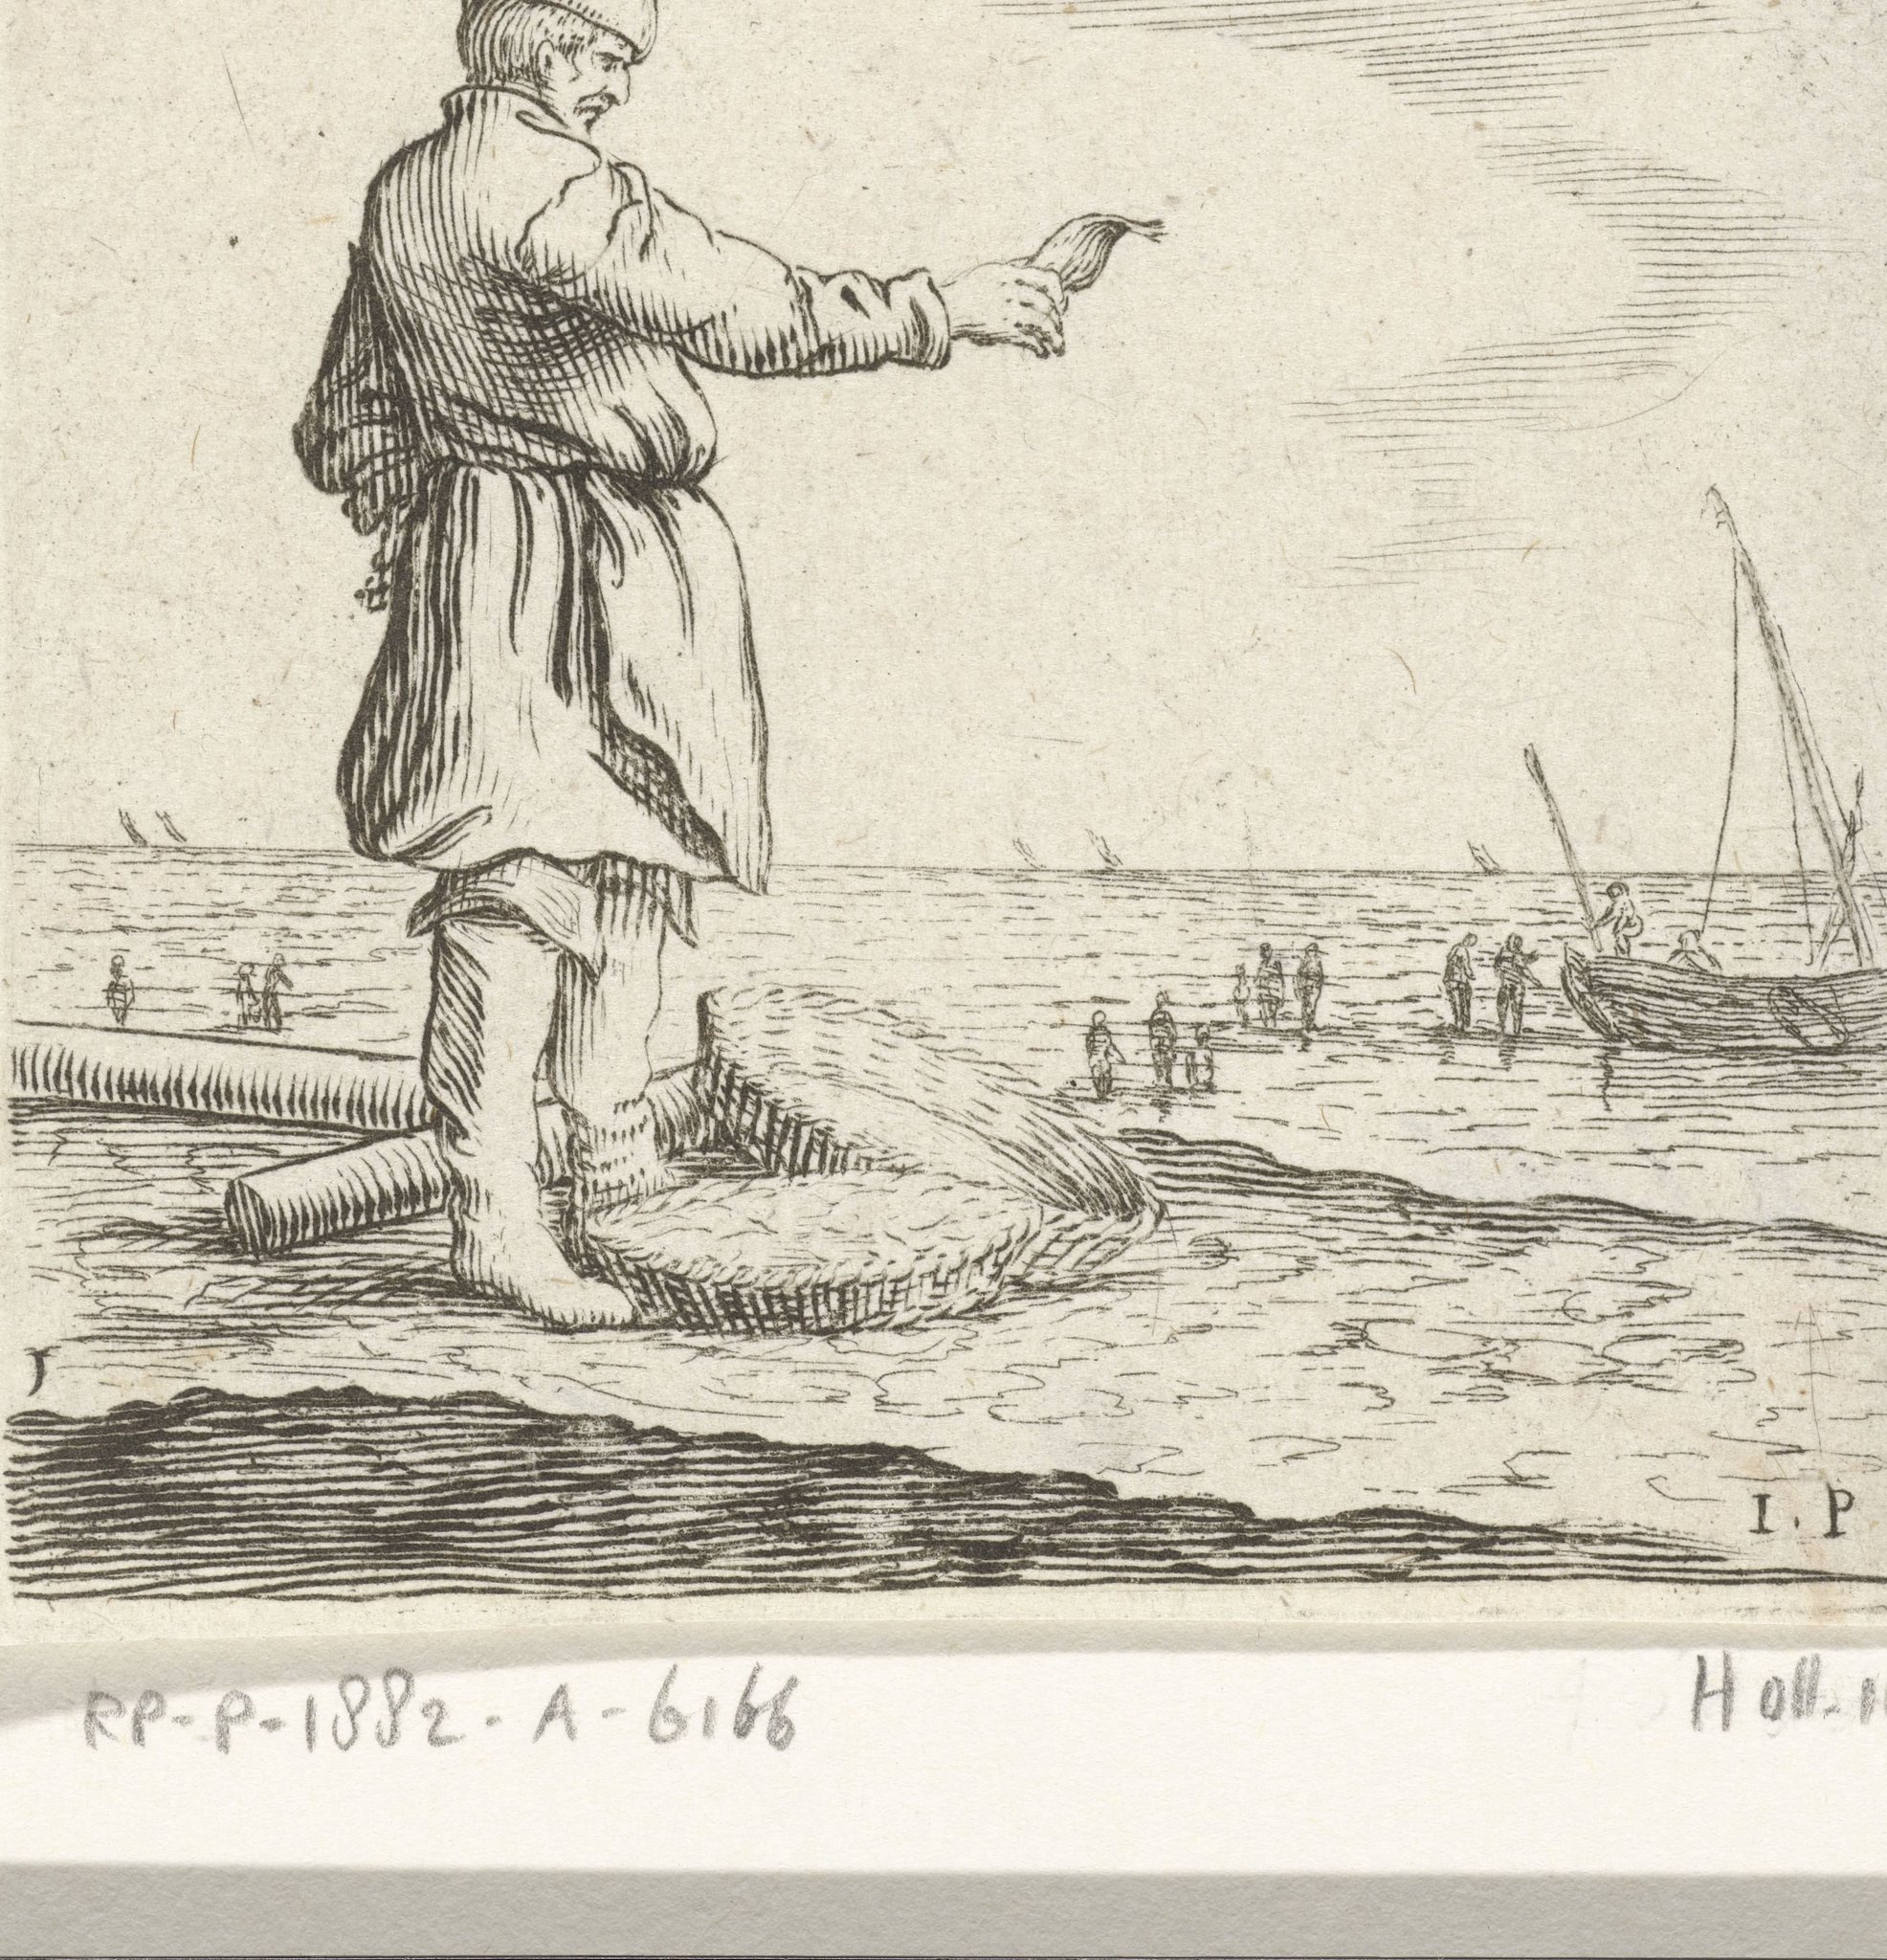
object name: print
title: Duinlandschap met een visser, met vis in de hand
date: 1603-1653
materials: paper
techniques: etching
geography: northern netherlands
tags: dune coast, fisherman showing catch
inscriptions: collector's mark: Lugt 2228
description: De prent is op een gegeven moment toegevoegd aan de serie "Verscheyden Stranden en water gesichten gedaen door Jan Percelles". Op dat moment is het serienummer gewijzigd.